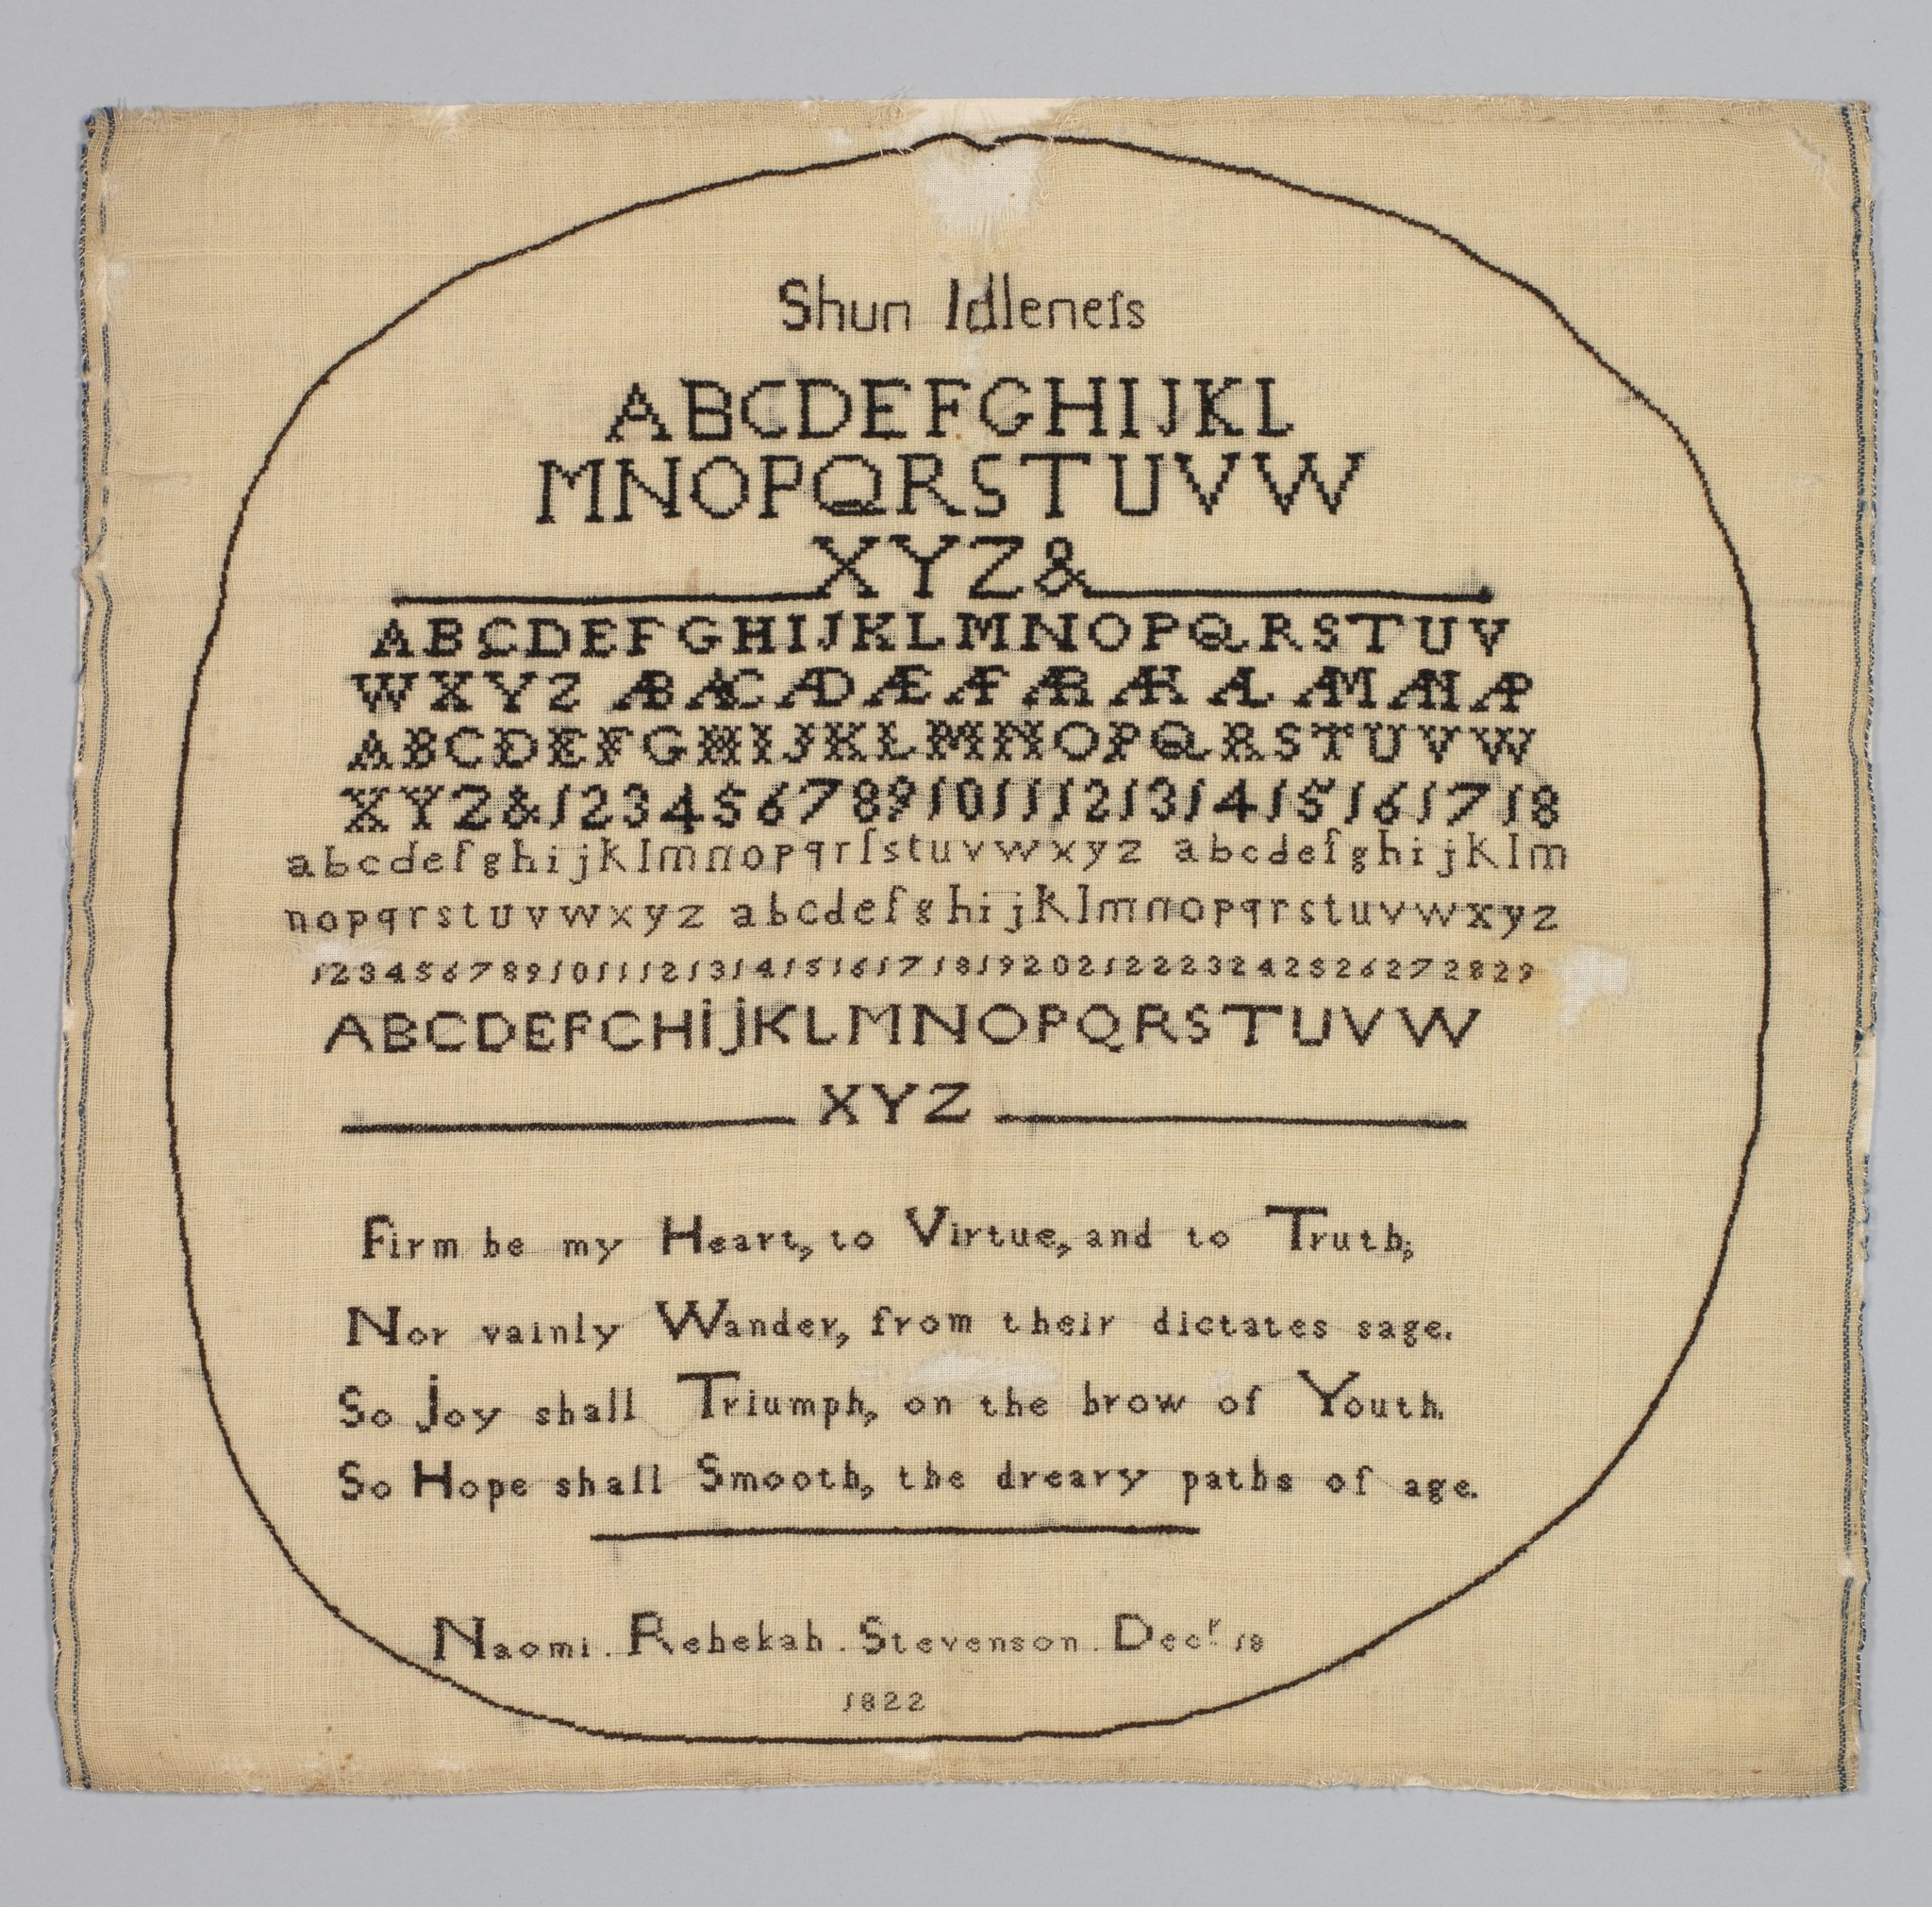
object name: sampler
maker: naomi rebekah stevenson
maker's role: maker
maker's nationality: british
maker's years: 1808-1908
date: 1822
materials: canvas, silk, wool